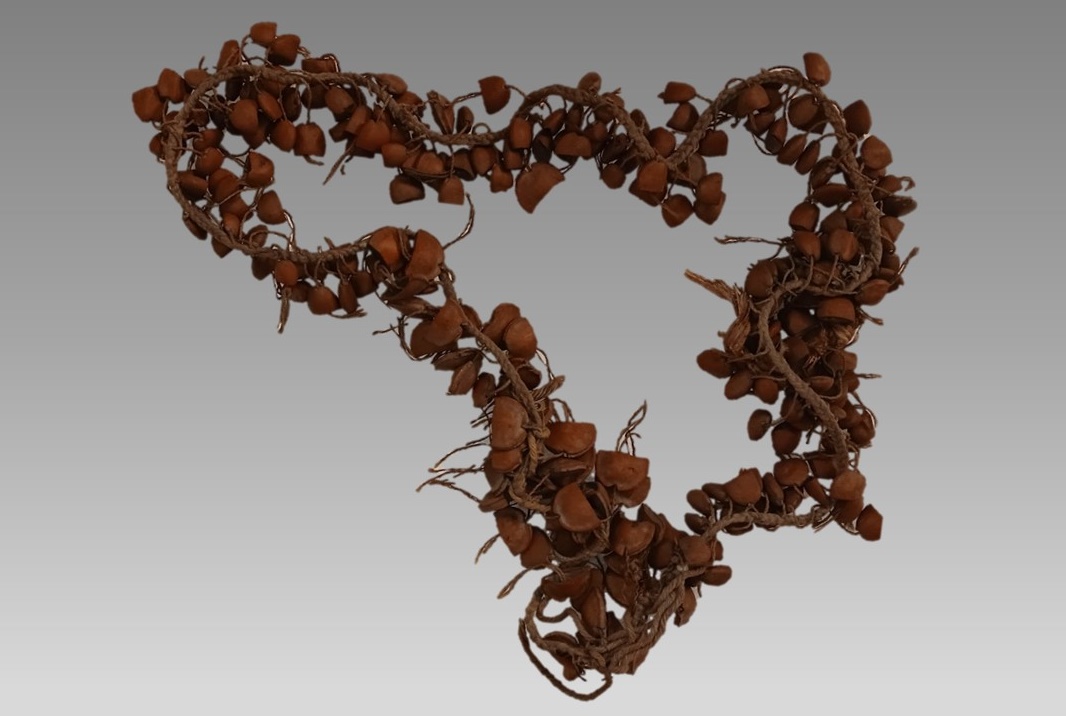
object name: strung rattle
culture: native american or guyanese or demerara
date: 1801-1900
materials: cord, cotton, shell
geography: guyana